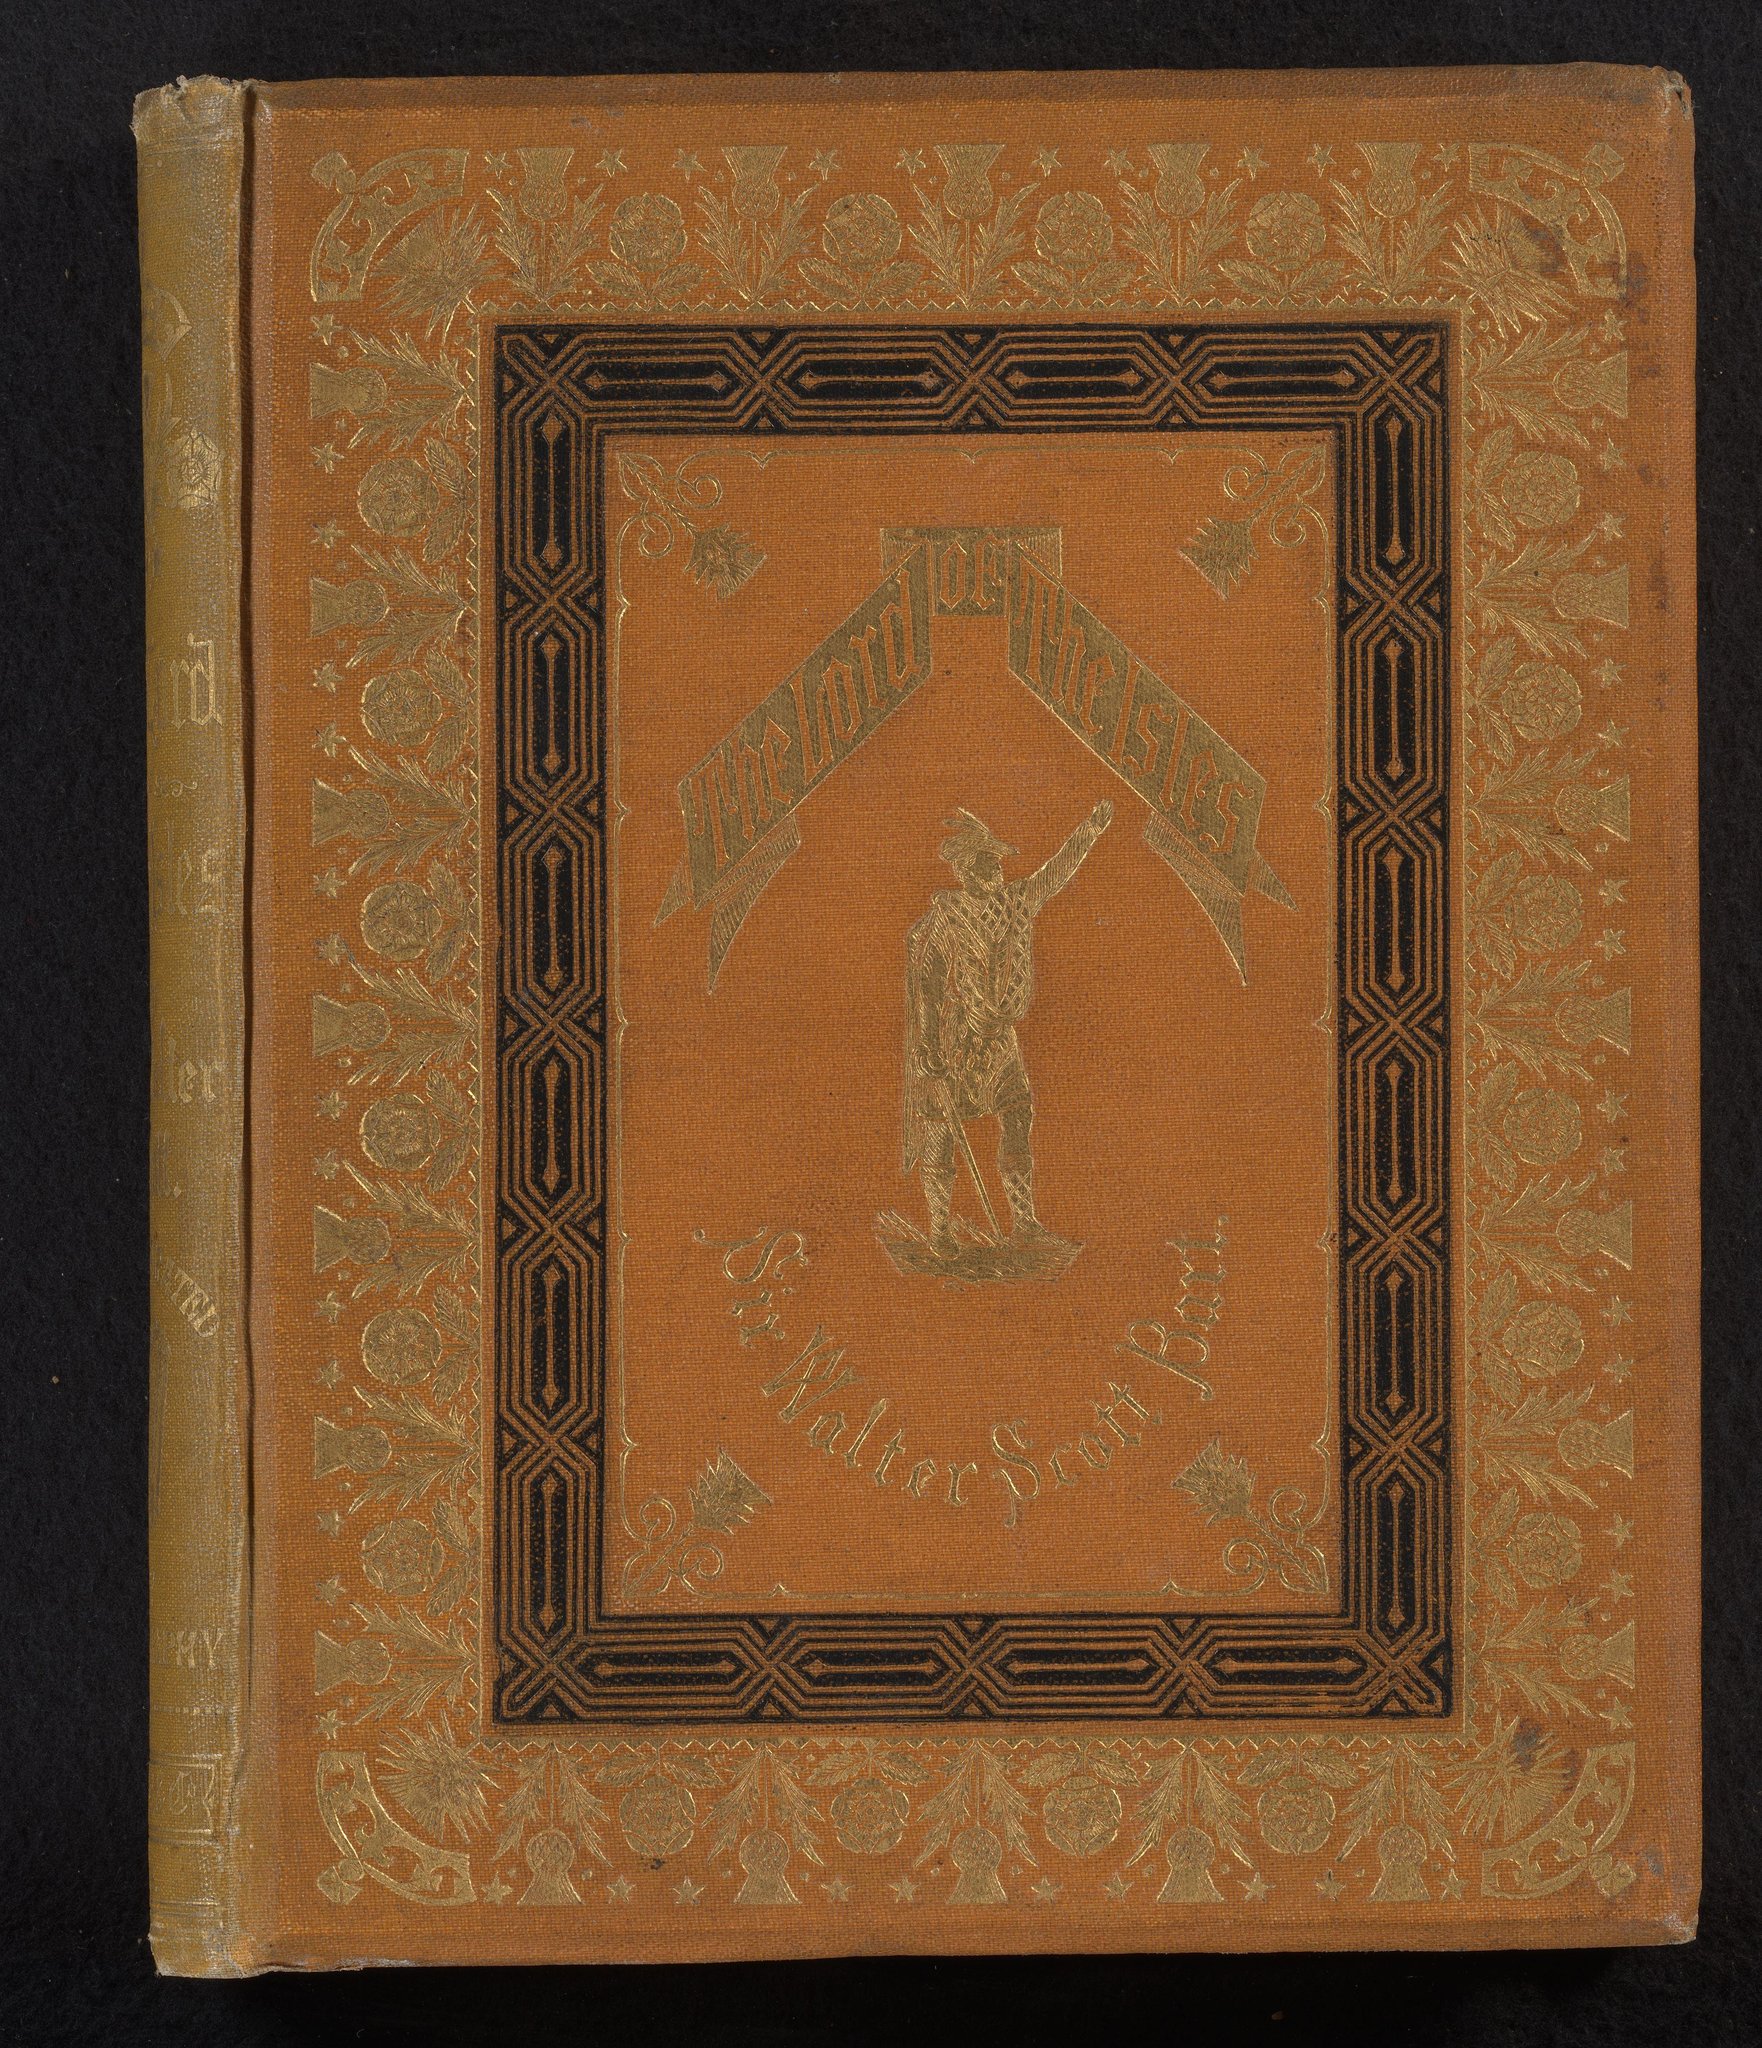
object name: book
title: The lord of the isles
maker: walter scott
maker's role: dichter, schrijver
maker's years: 1771-1832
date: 1871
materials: cardboard, linen, paper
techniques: albumen print, letterpress printing, printing block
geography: london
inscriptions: inscription: ‘BOUND BY/ WESTLEYS & CO/ LONDON’